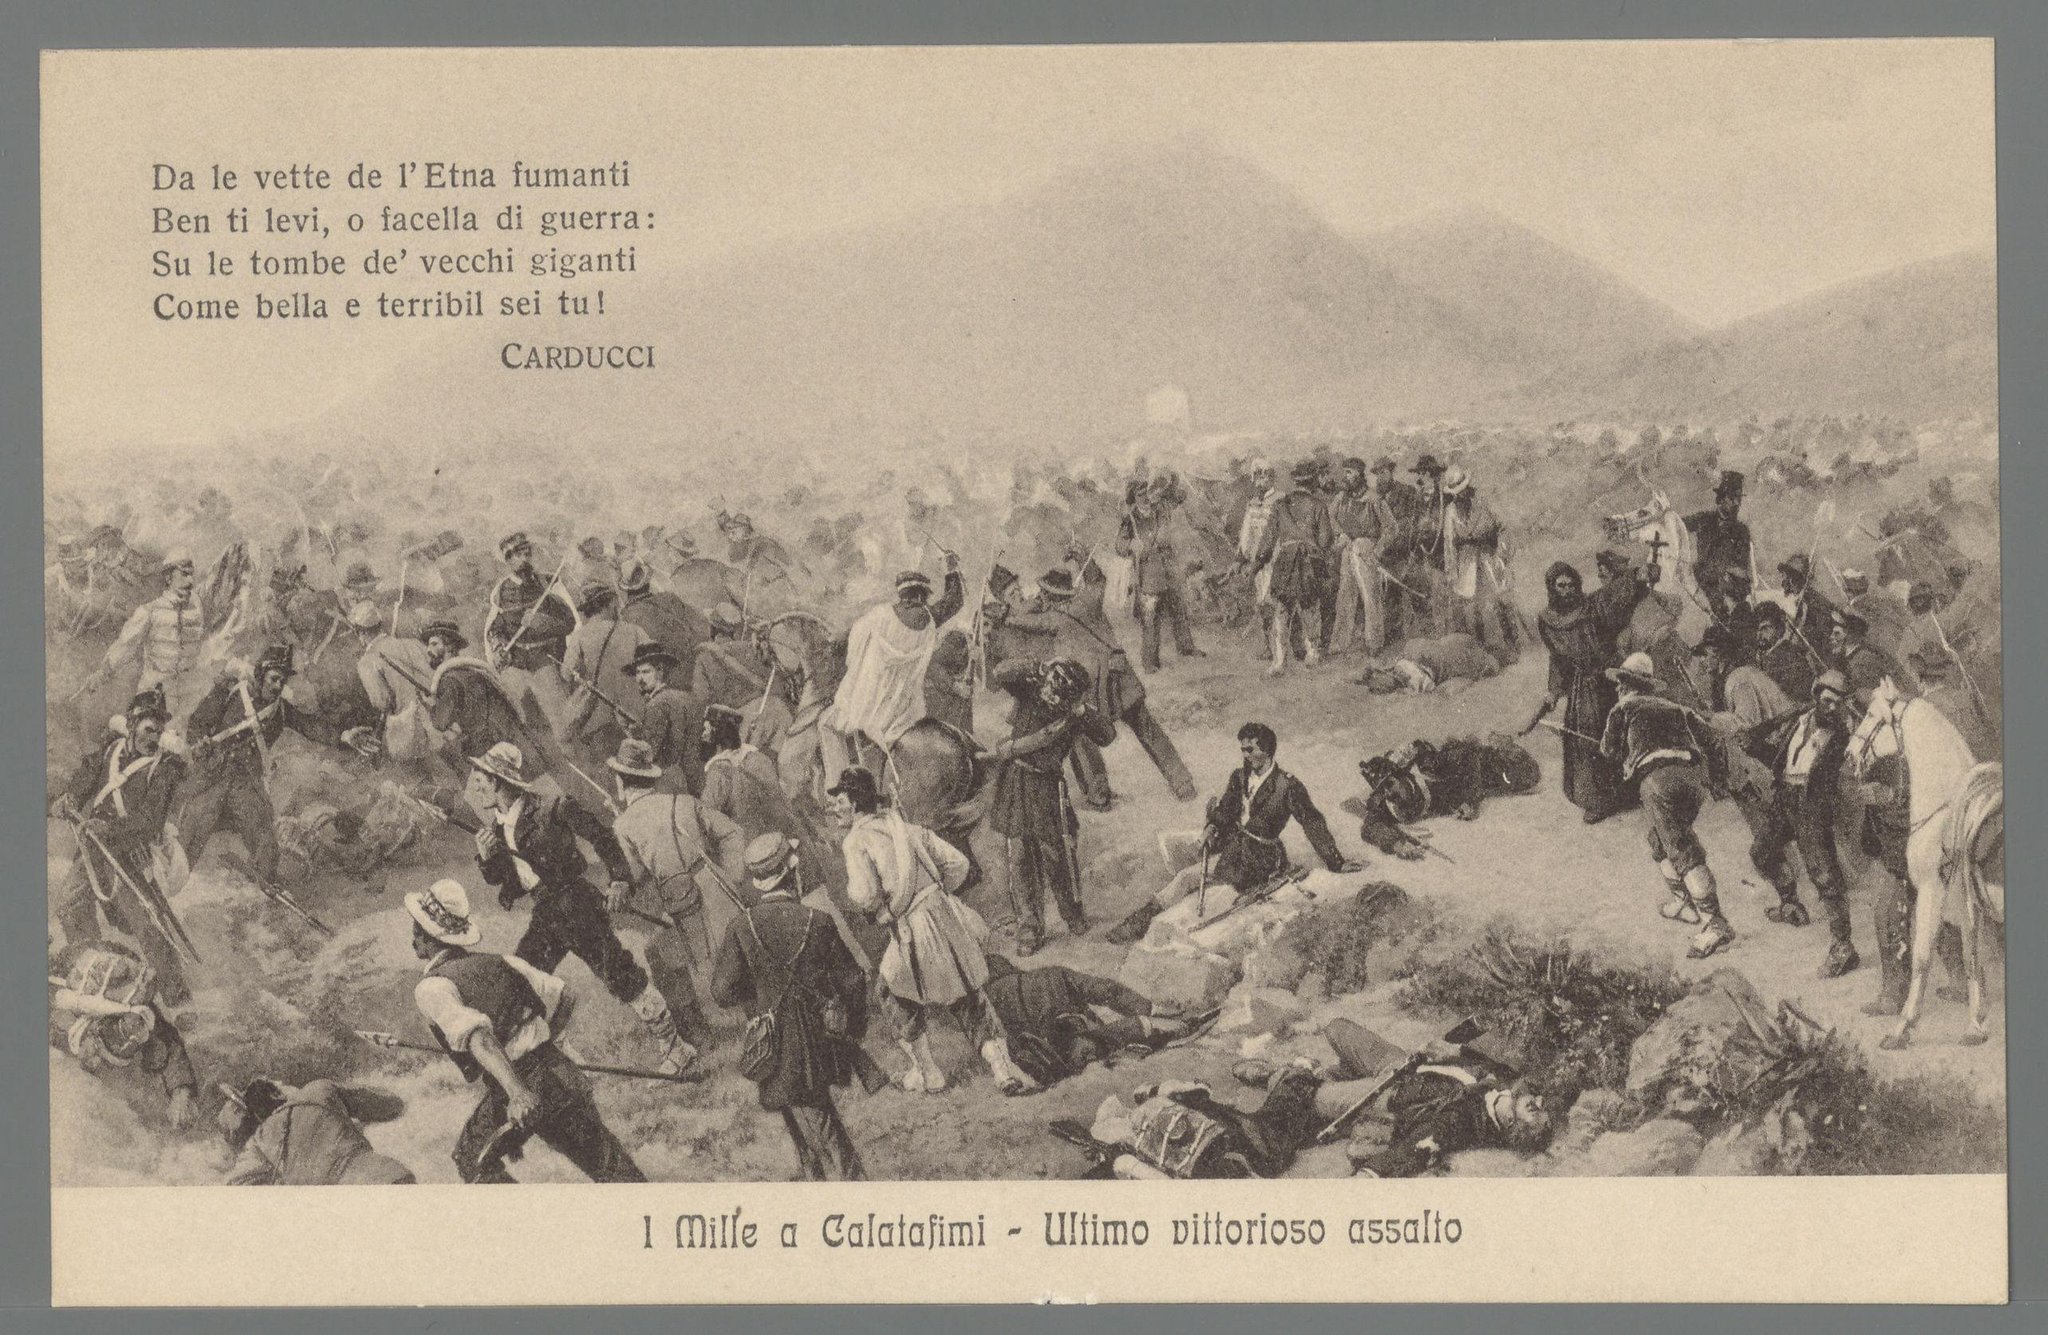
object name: ansichtkaart, prentbriefkaart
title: I Mille a Calatafimi. Ultimo vittorioso assalto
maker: Anonymous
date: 1906-1910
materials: cardboard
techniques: photograph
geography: terni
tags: battle (+ land forces)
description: Voorstelling van de veldslag van Calatafimi. Linksboven een gedicht van Carducci.